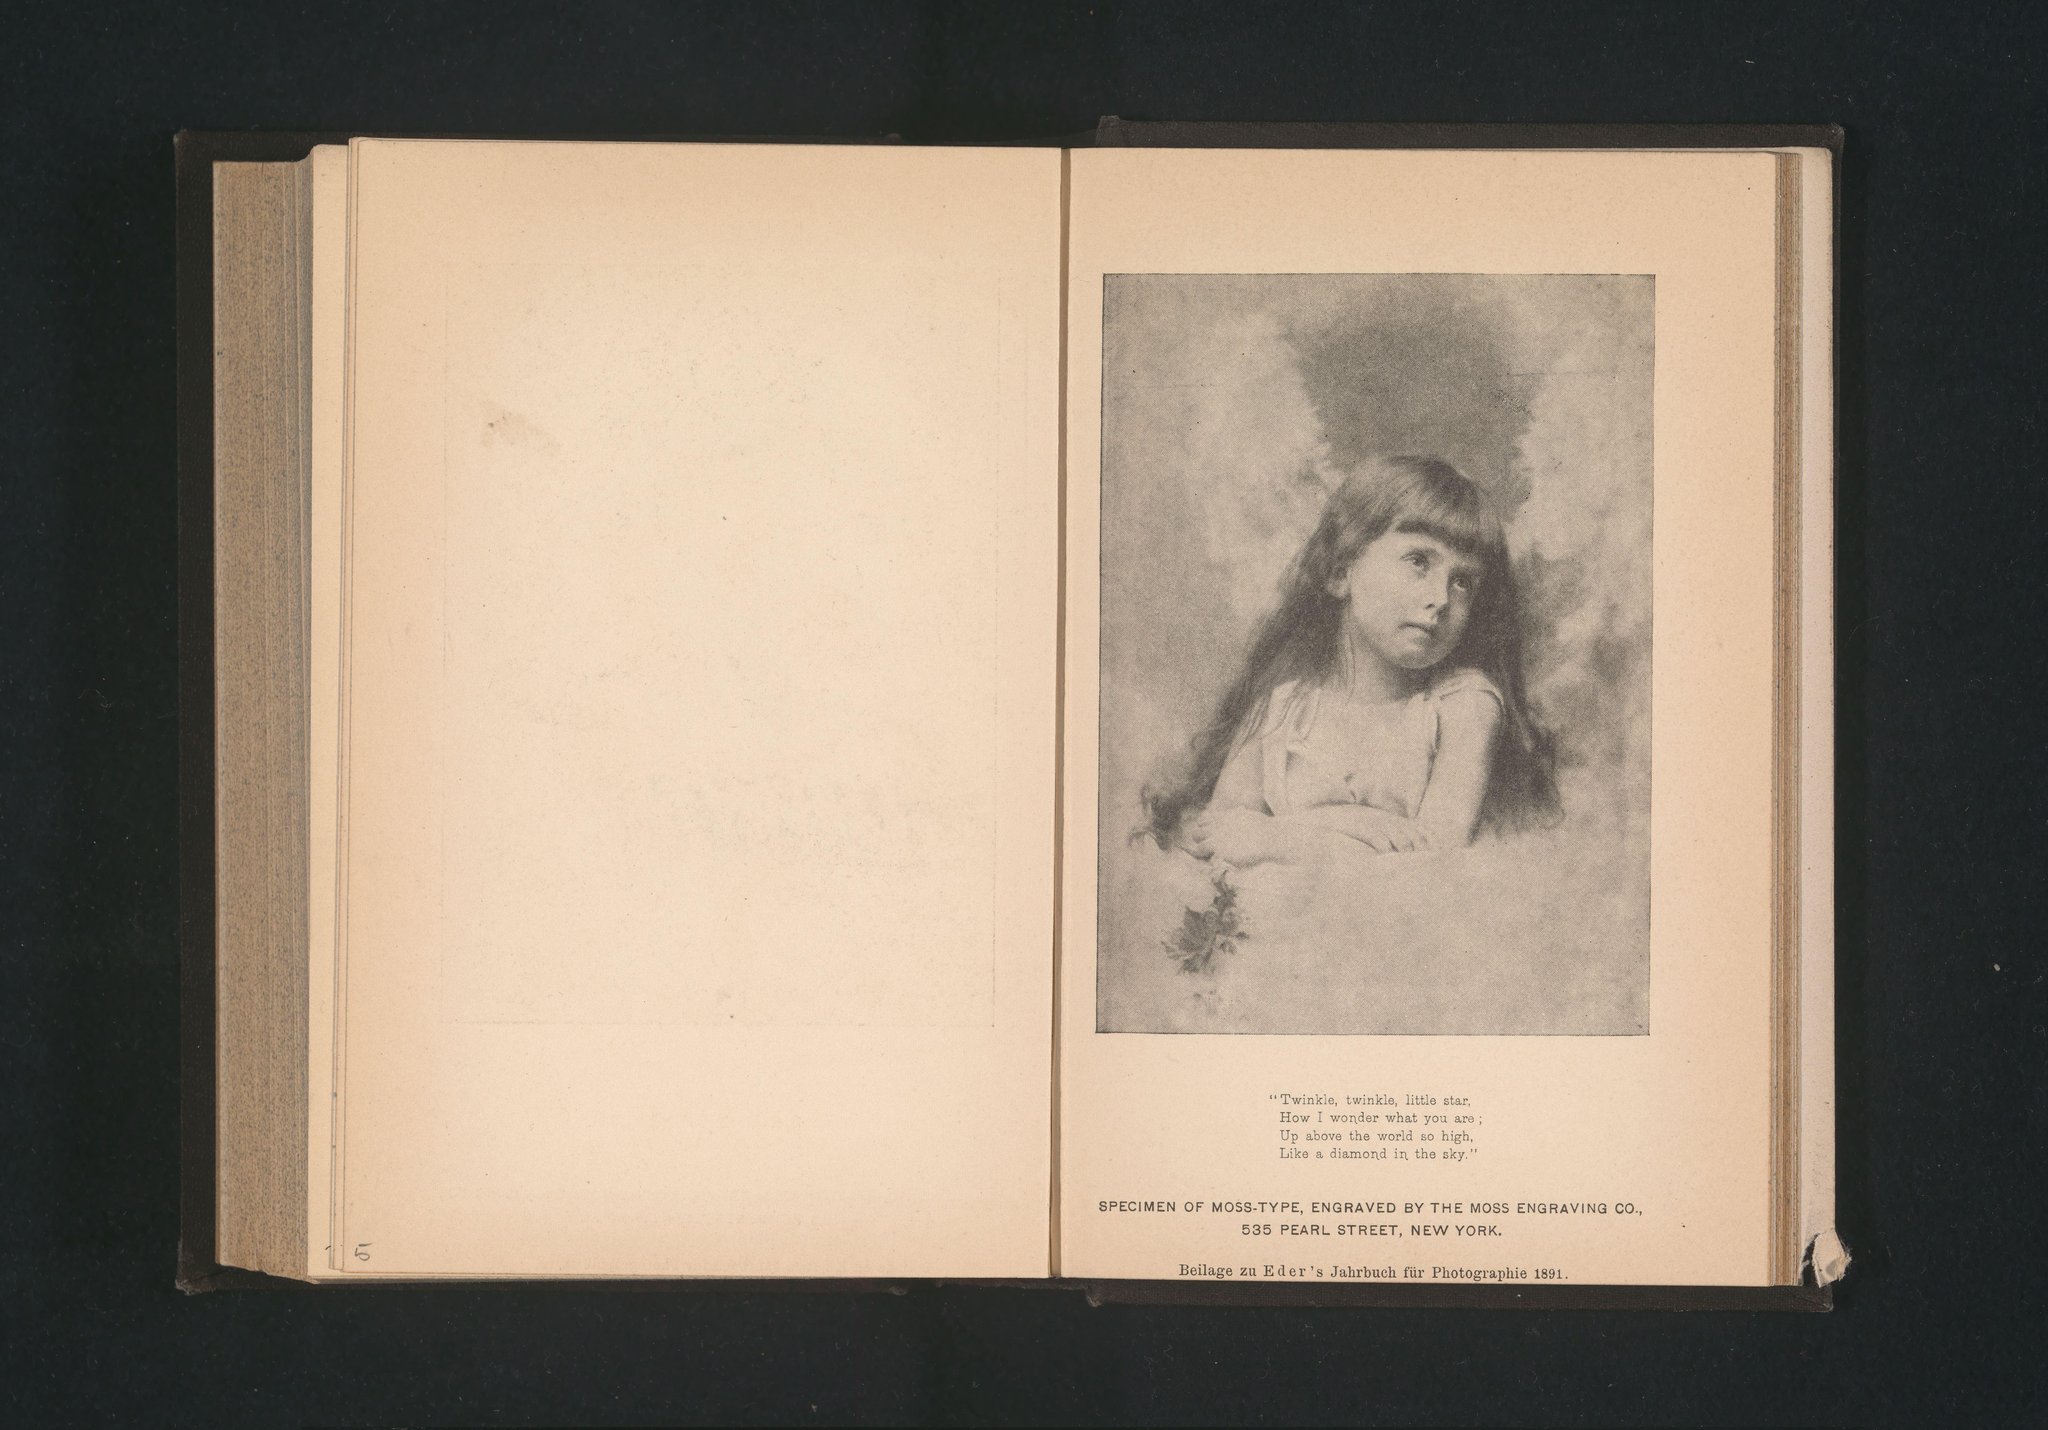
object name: page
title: Portret van een onbekend meisje omgeven door wolken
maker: Anonymous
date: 1886-1891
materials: paper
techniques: autotype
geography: new york city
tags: historical persons - bb - woman, clouds, girl (child between toddler and youth)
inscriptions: inscription: ‘"Twinkle, twinkle, little star, How I wonder what you are; Up above the world so high, Like a diamond in the sky."/ Beilage zu Eder's Jahbruch für Photographie 1891’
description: Prent op veertiende ongenummerde pagina na pagina 627.